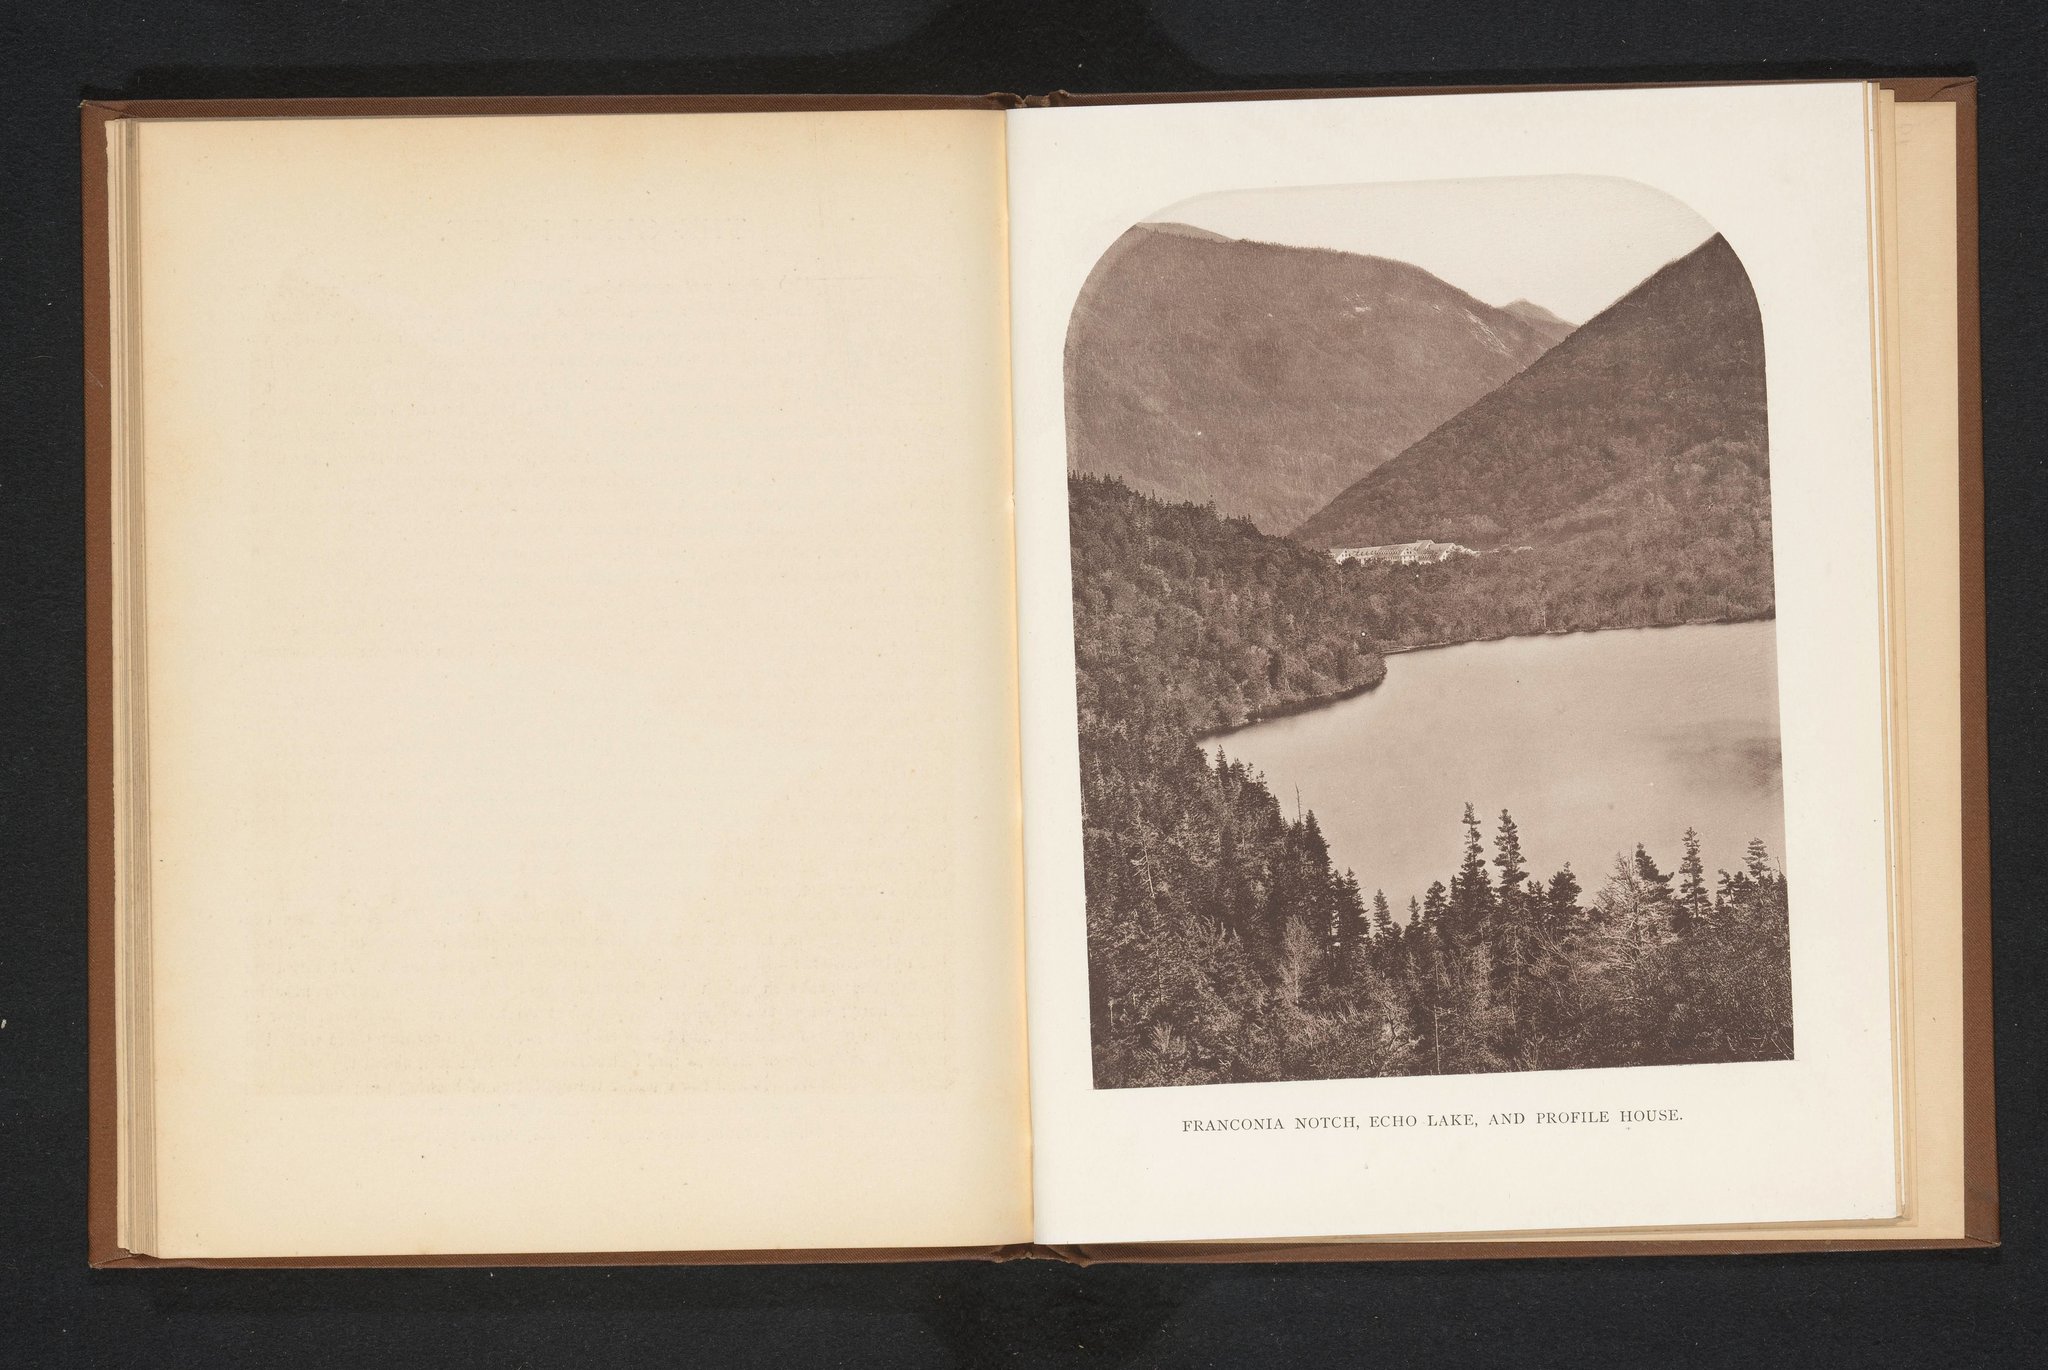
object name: photomechanical print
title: Franconia Notch, Echo Lake, and Profile House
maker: Anonymous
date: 1874-1879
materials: paper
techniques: photograph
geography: white mountains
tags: lake, hotel, hostelry, inn, mountains